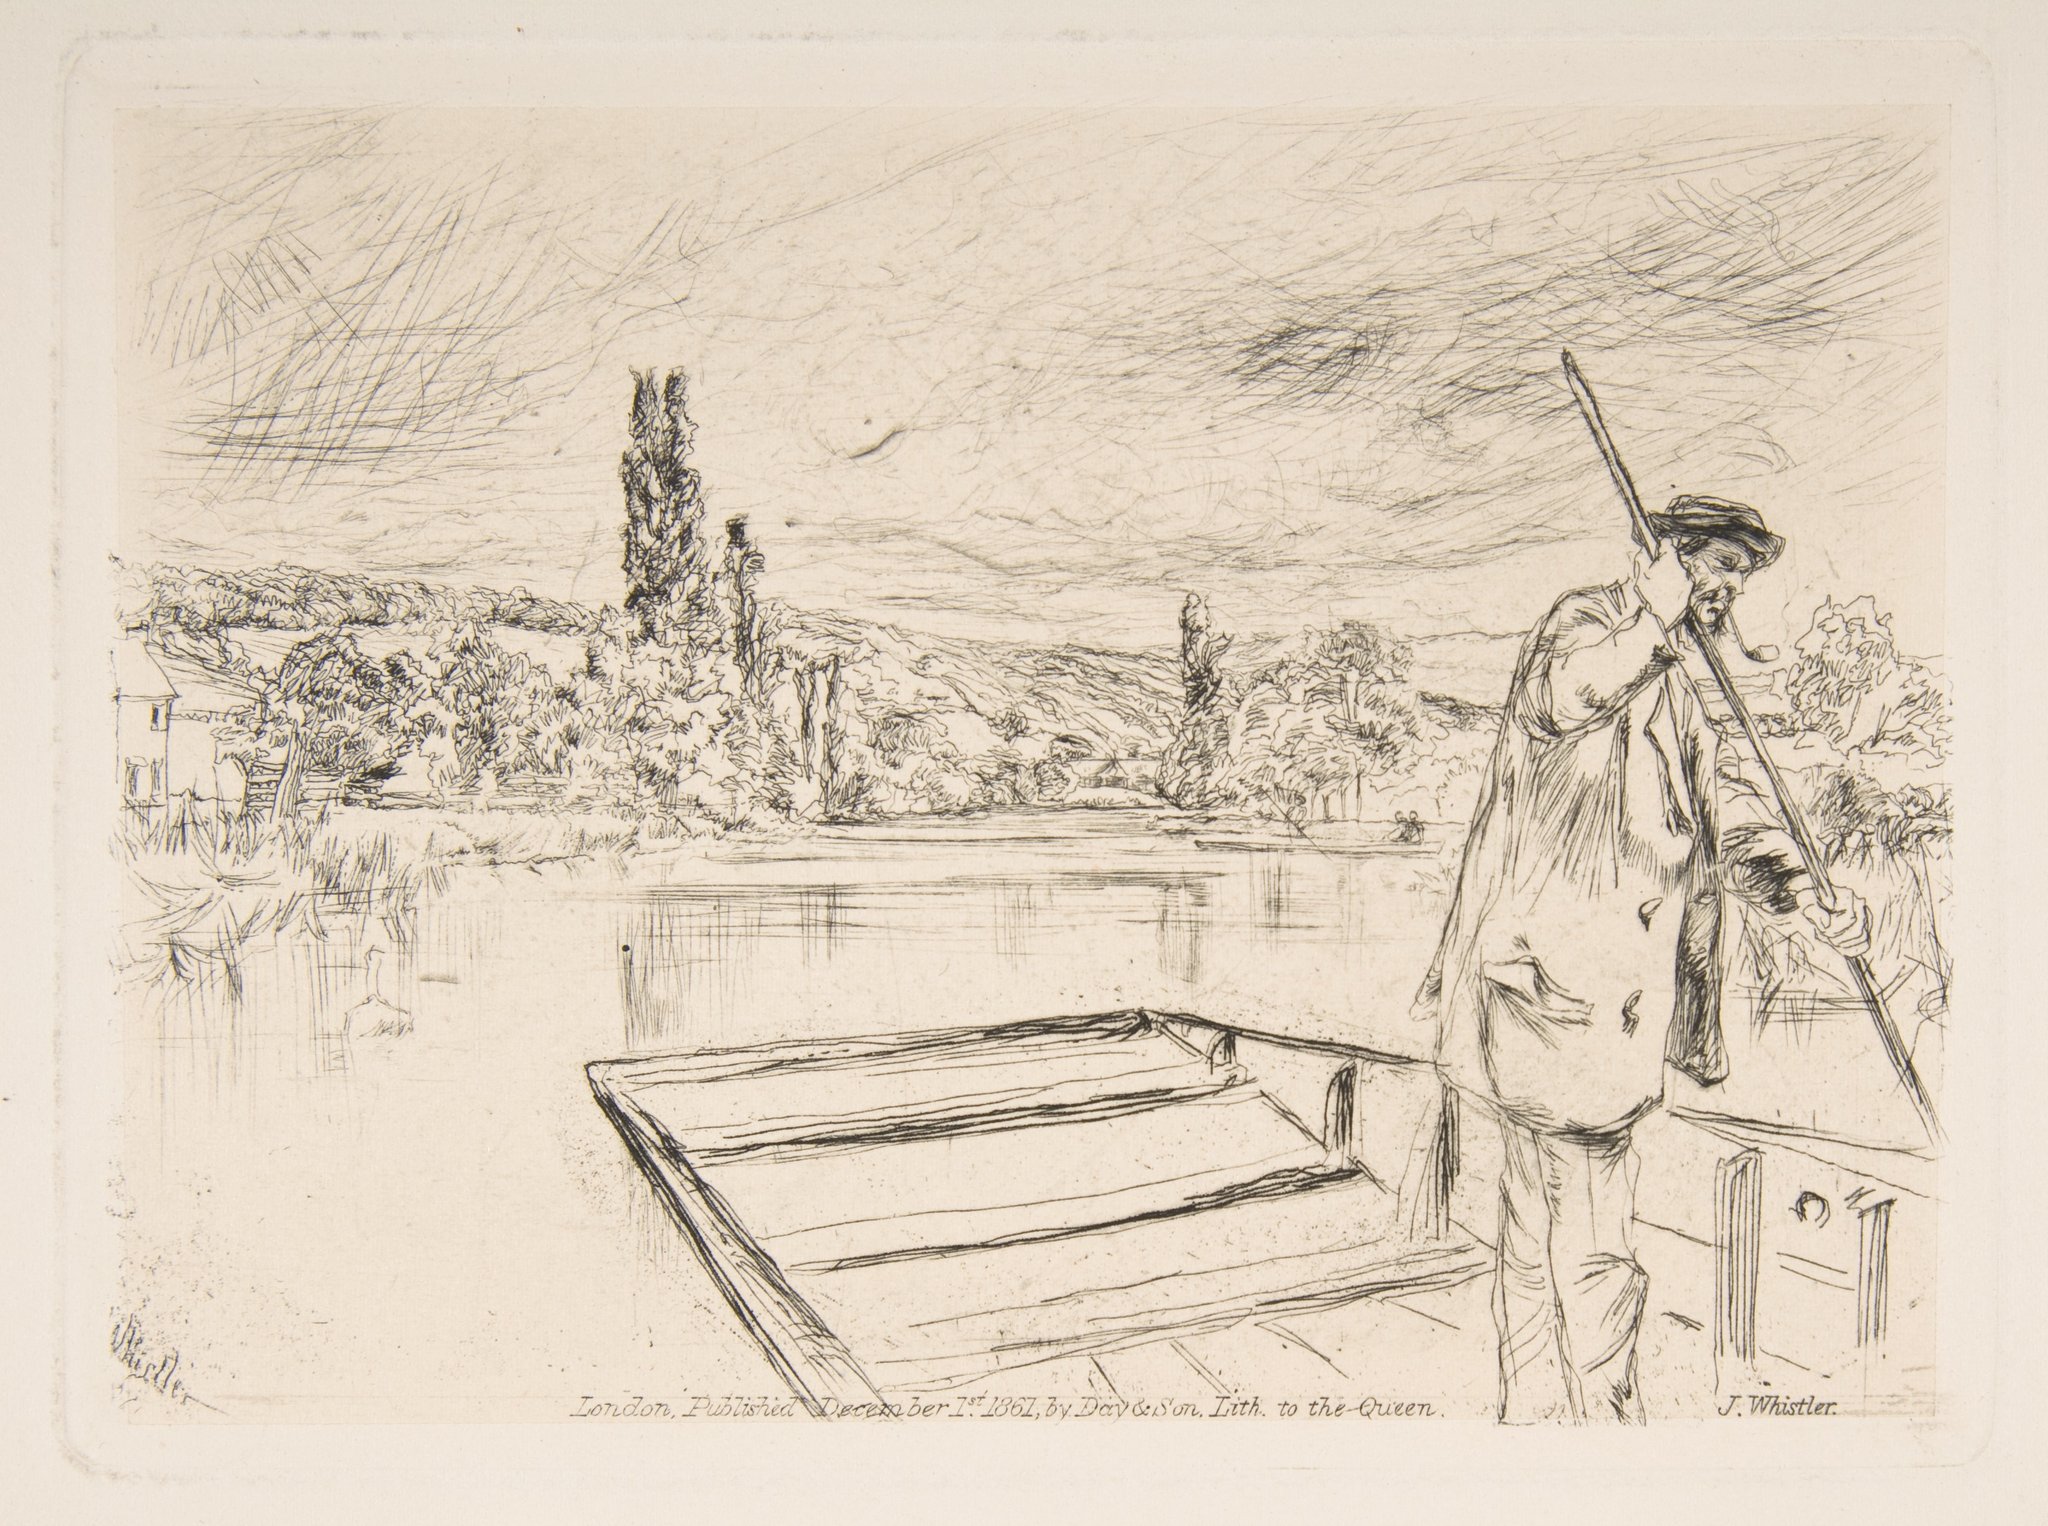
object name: print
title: The Punt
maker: james mcneill whistler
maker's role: artist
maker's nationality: american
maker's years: 1834-1903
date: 1861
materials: chine, ivory, paper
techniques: printmaking, drypoint, etching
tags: men,smoking,rivers,boats